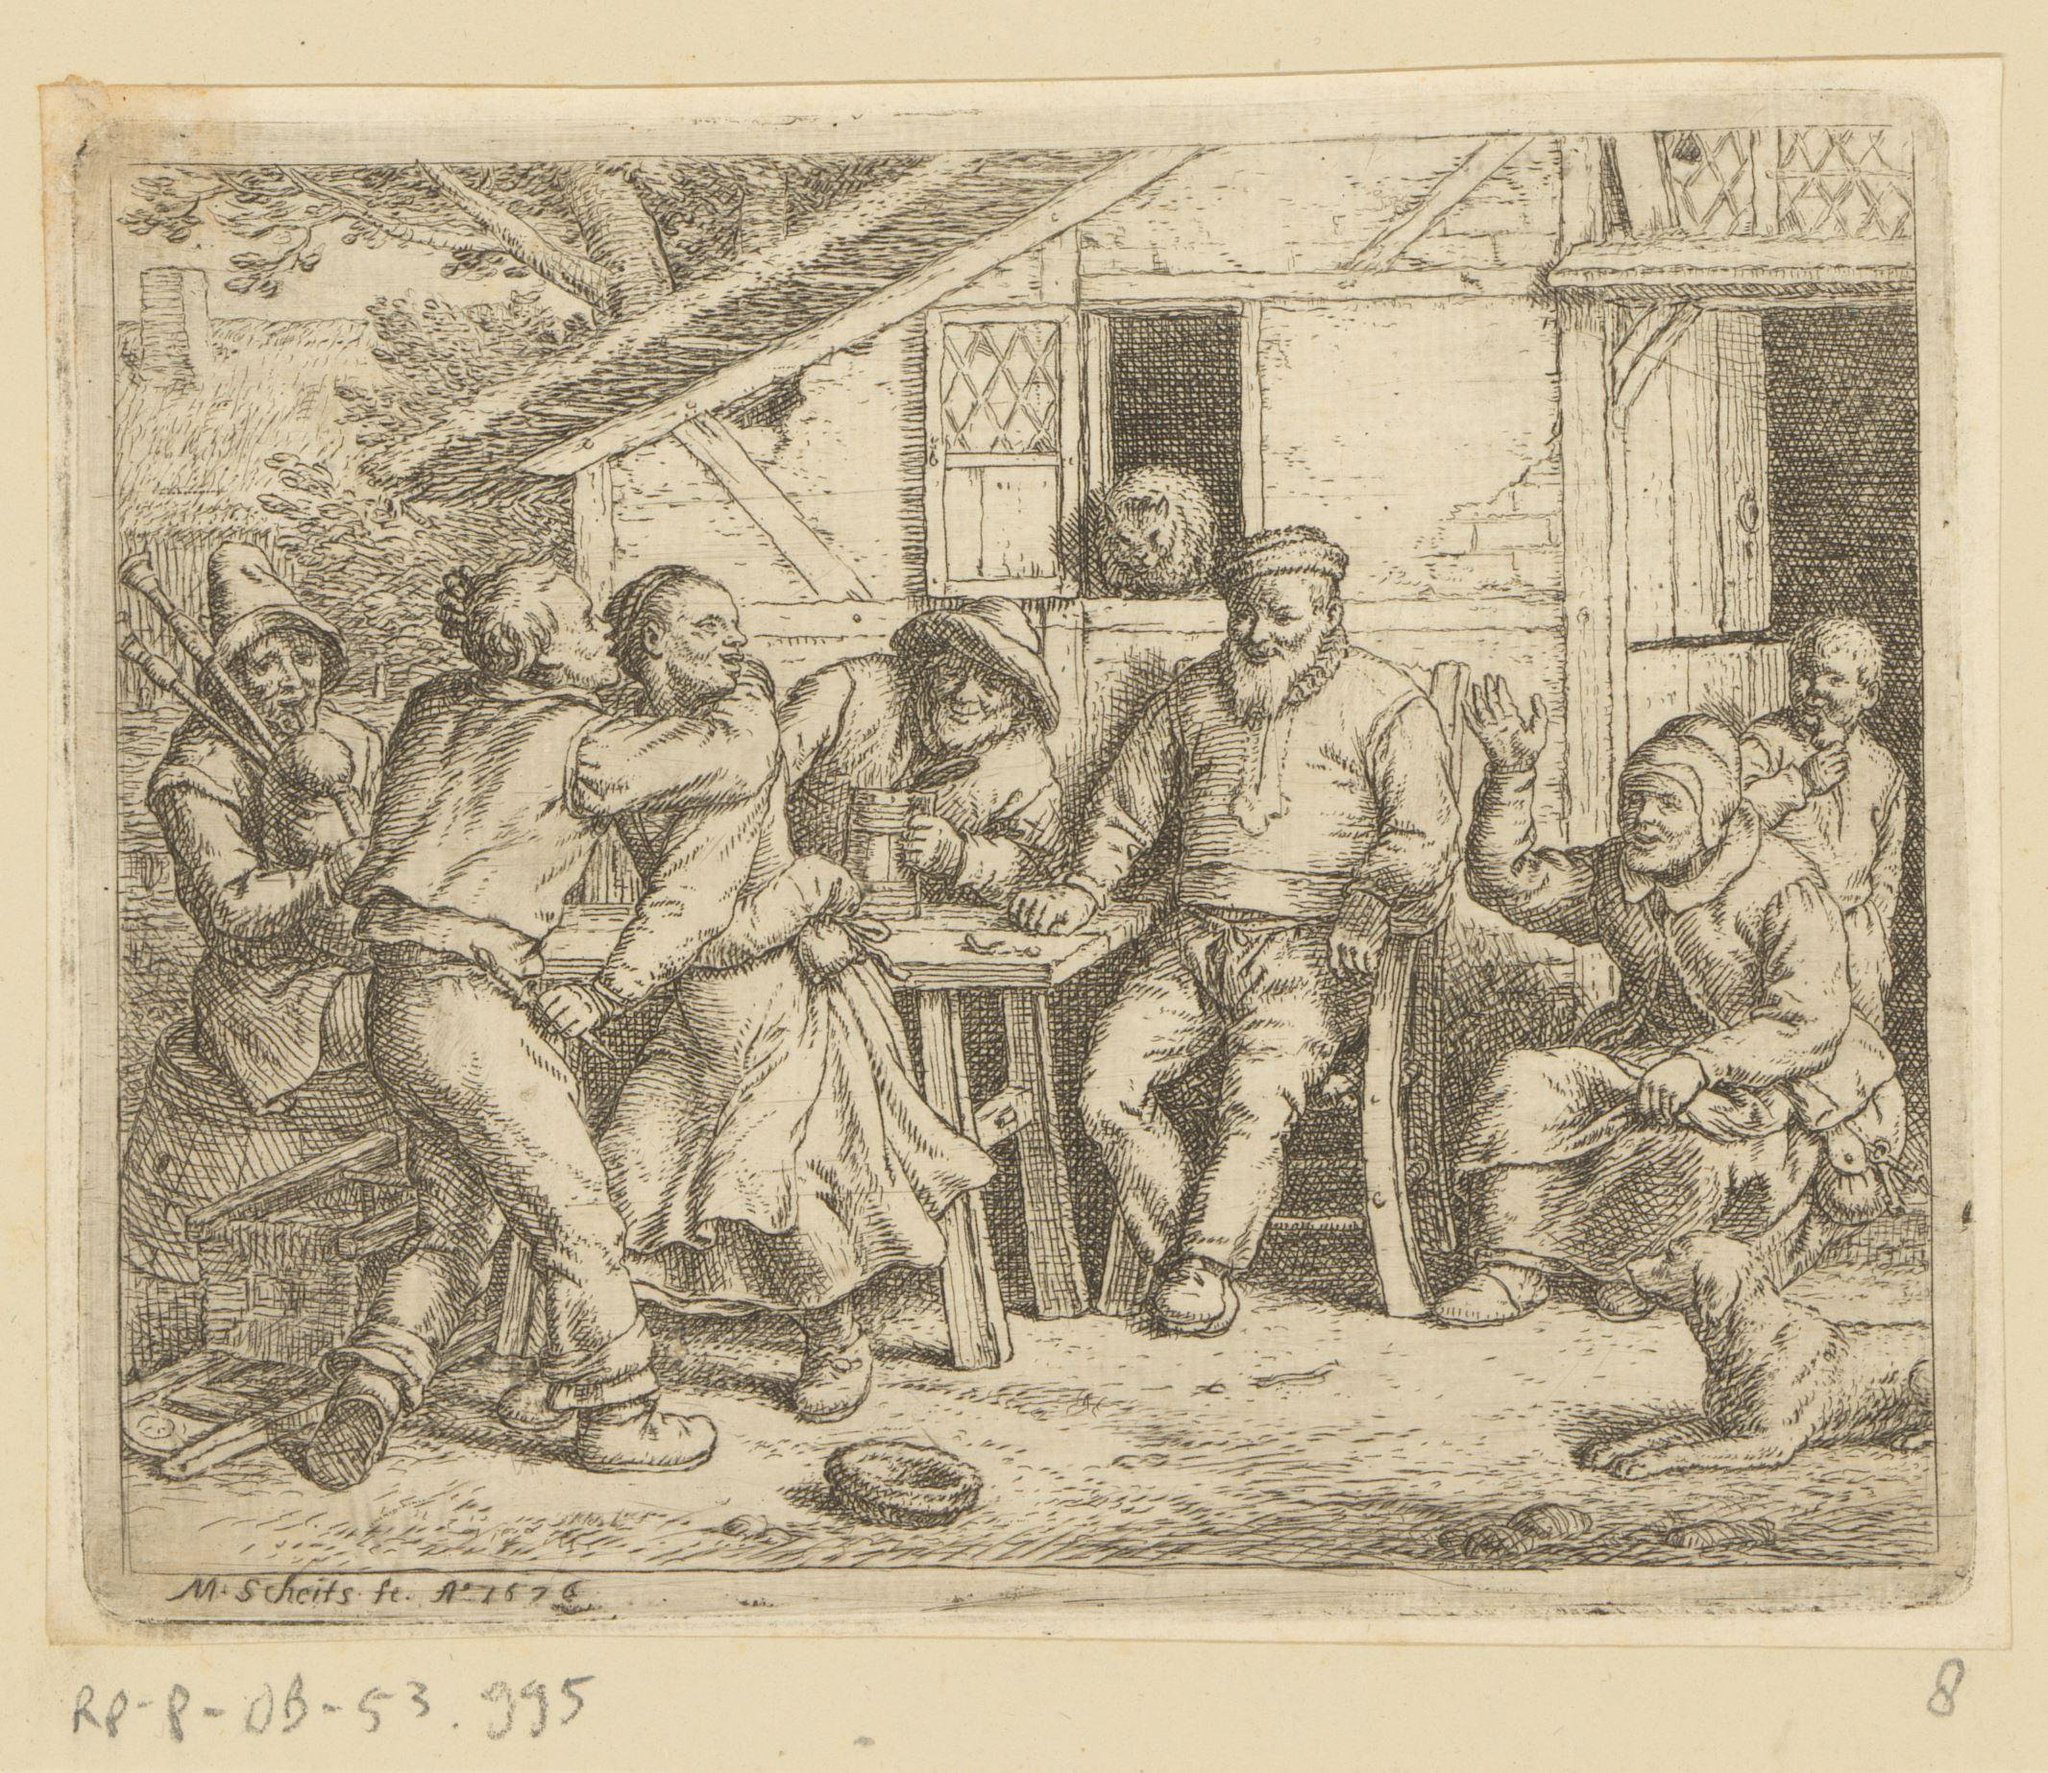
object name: print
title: Gezelschap boeren mannen en vrouwen aan tafel voor een huis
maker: matthias scheits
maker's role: print maker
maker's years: 1625-1700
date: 1676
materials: paper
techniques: etching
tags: farmers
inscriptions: collector's mark: Lugt 240